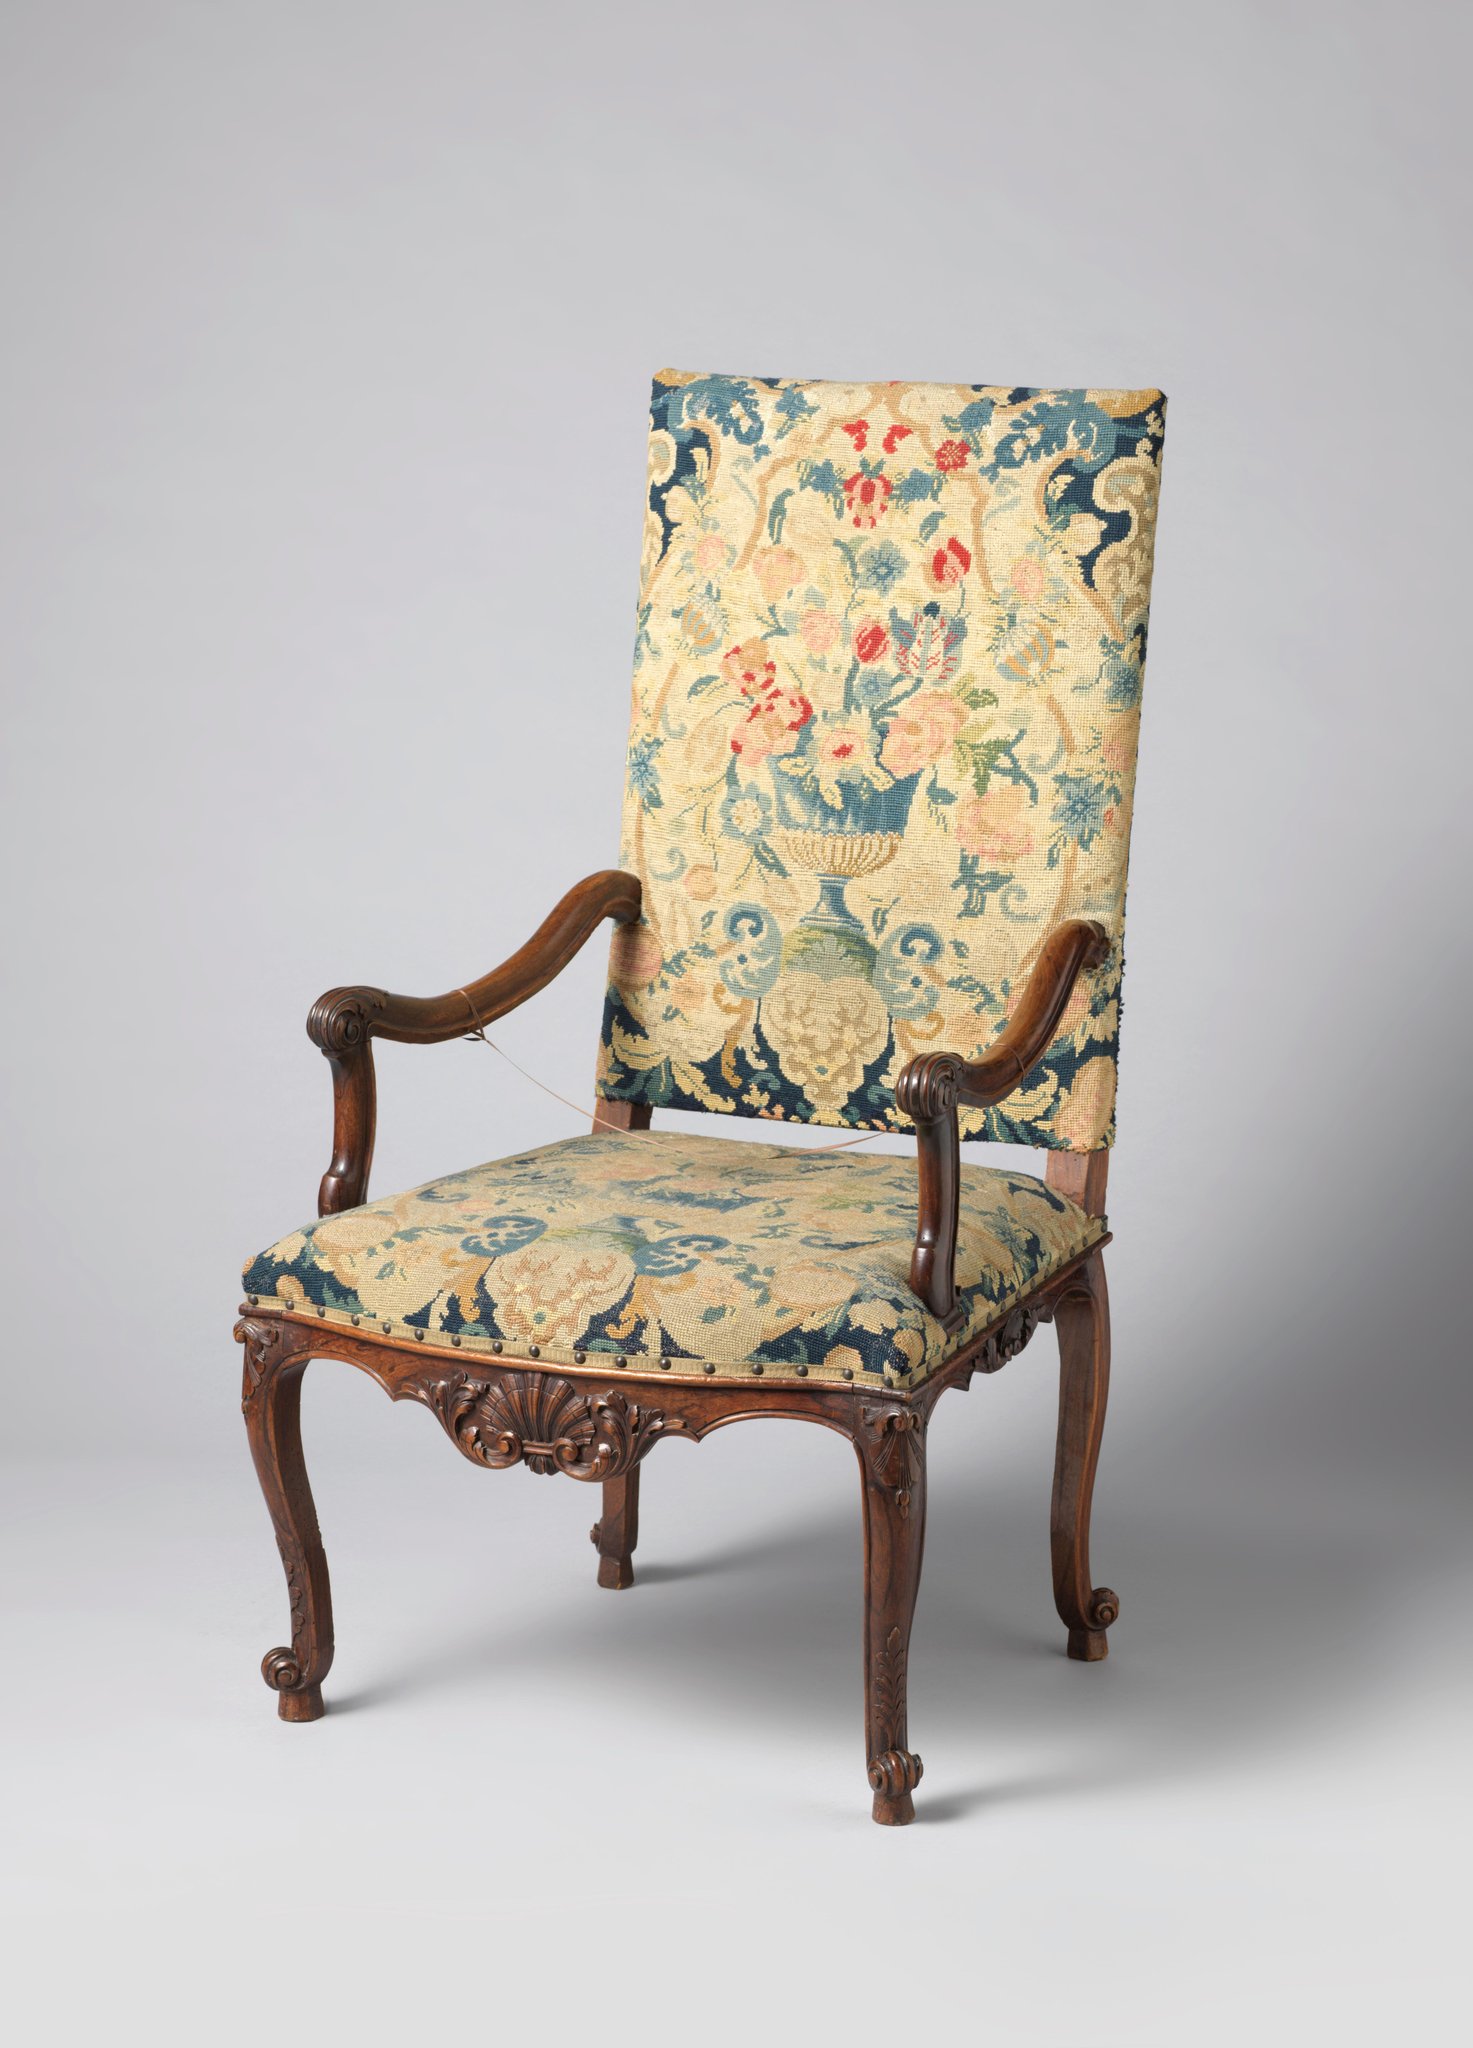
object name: armchair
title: Armstoel van notenhout met petit-point bekleding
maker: Anonymous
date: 1700-1725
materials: wood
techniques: embroidered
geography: northern netherlands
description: Side-table. Beech, gilded. Munich, c. 1730, possibly designed by Joseph Effner. Attributed to Jean-Louis Lemoyne(1665 - 1755). Elizabeth-Marie-Suzanne Le Detz. Terracotta, marble base. Paris, c. 1720. Two armchairs. Walnut, upholstered with wool and silk embroidery. Netherlands, c. 1715 - 1730. Originally from Kasteel Eerde near Ommen in the province of Overijssel. Tapestry with Diana resting from the hunt, from a set of classical gods. Wool and silk. Brussels, c. 1700 - 1750, probably designed and woven by a member of the Van der Borght family. Given by the Bank voor Handel en Scheepvaart, Rotterdam, 1955.